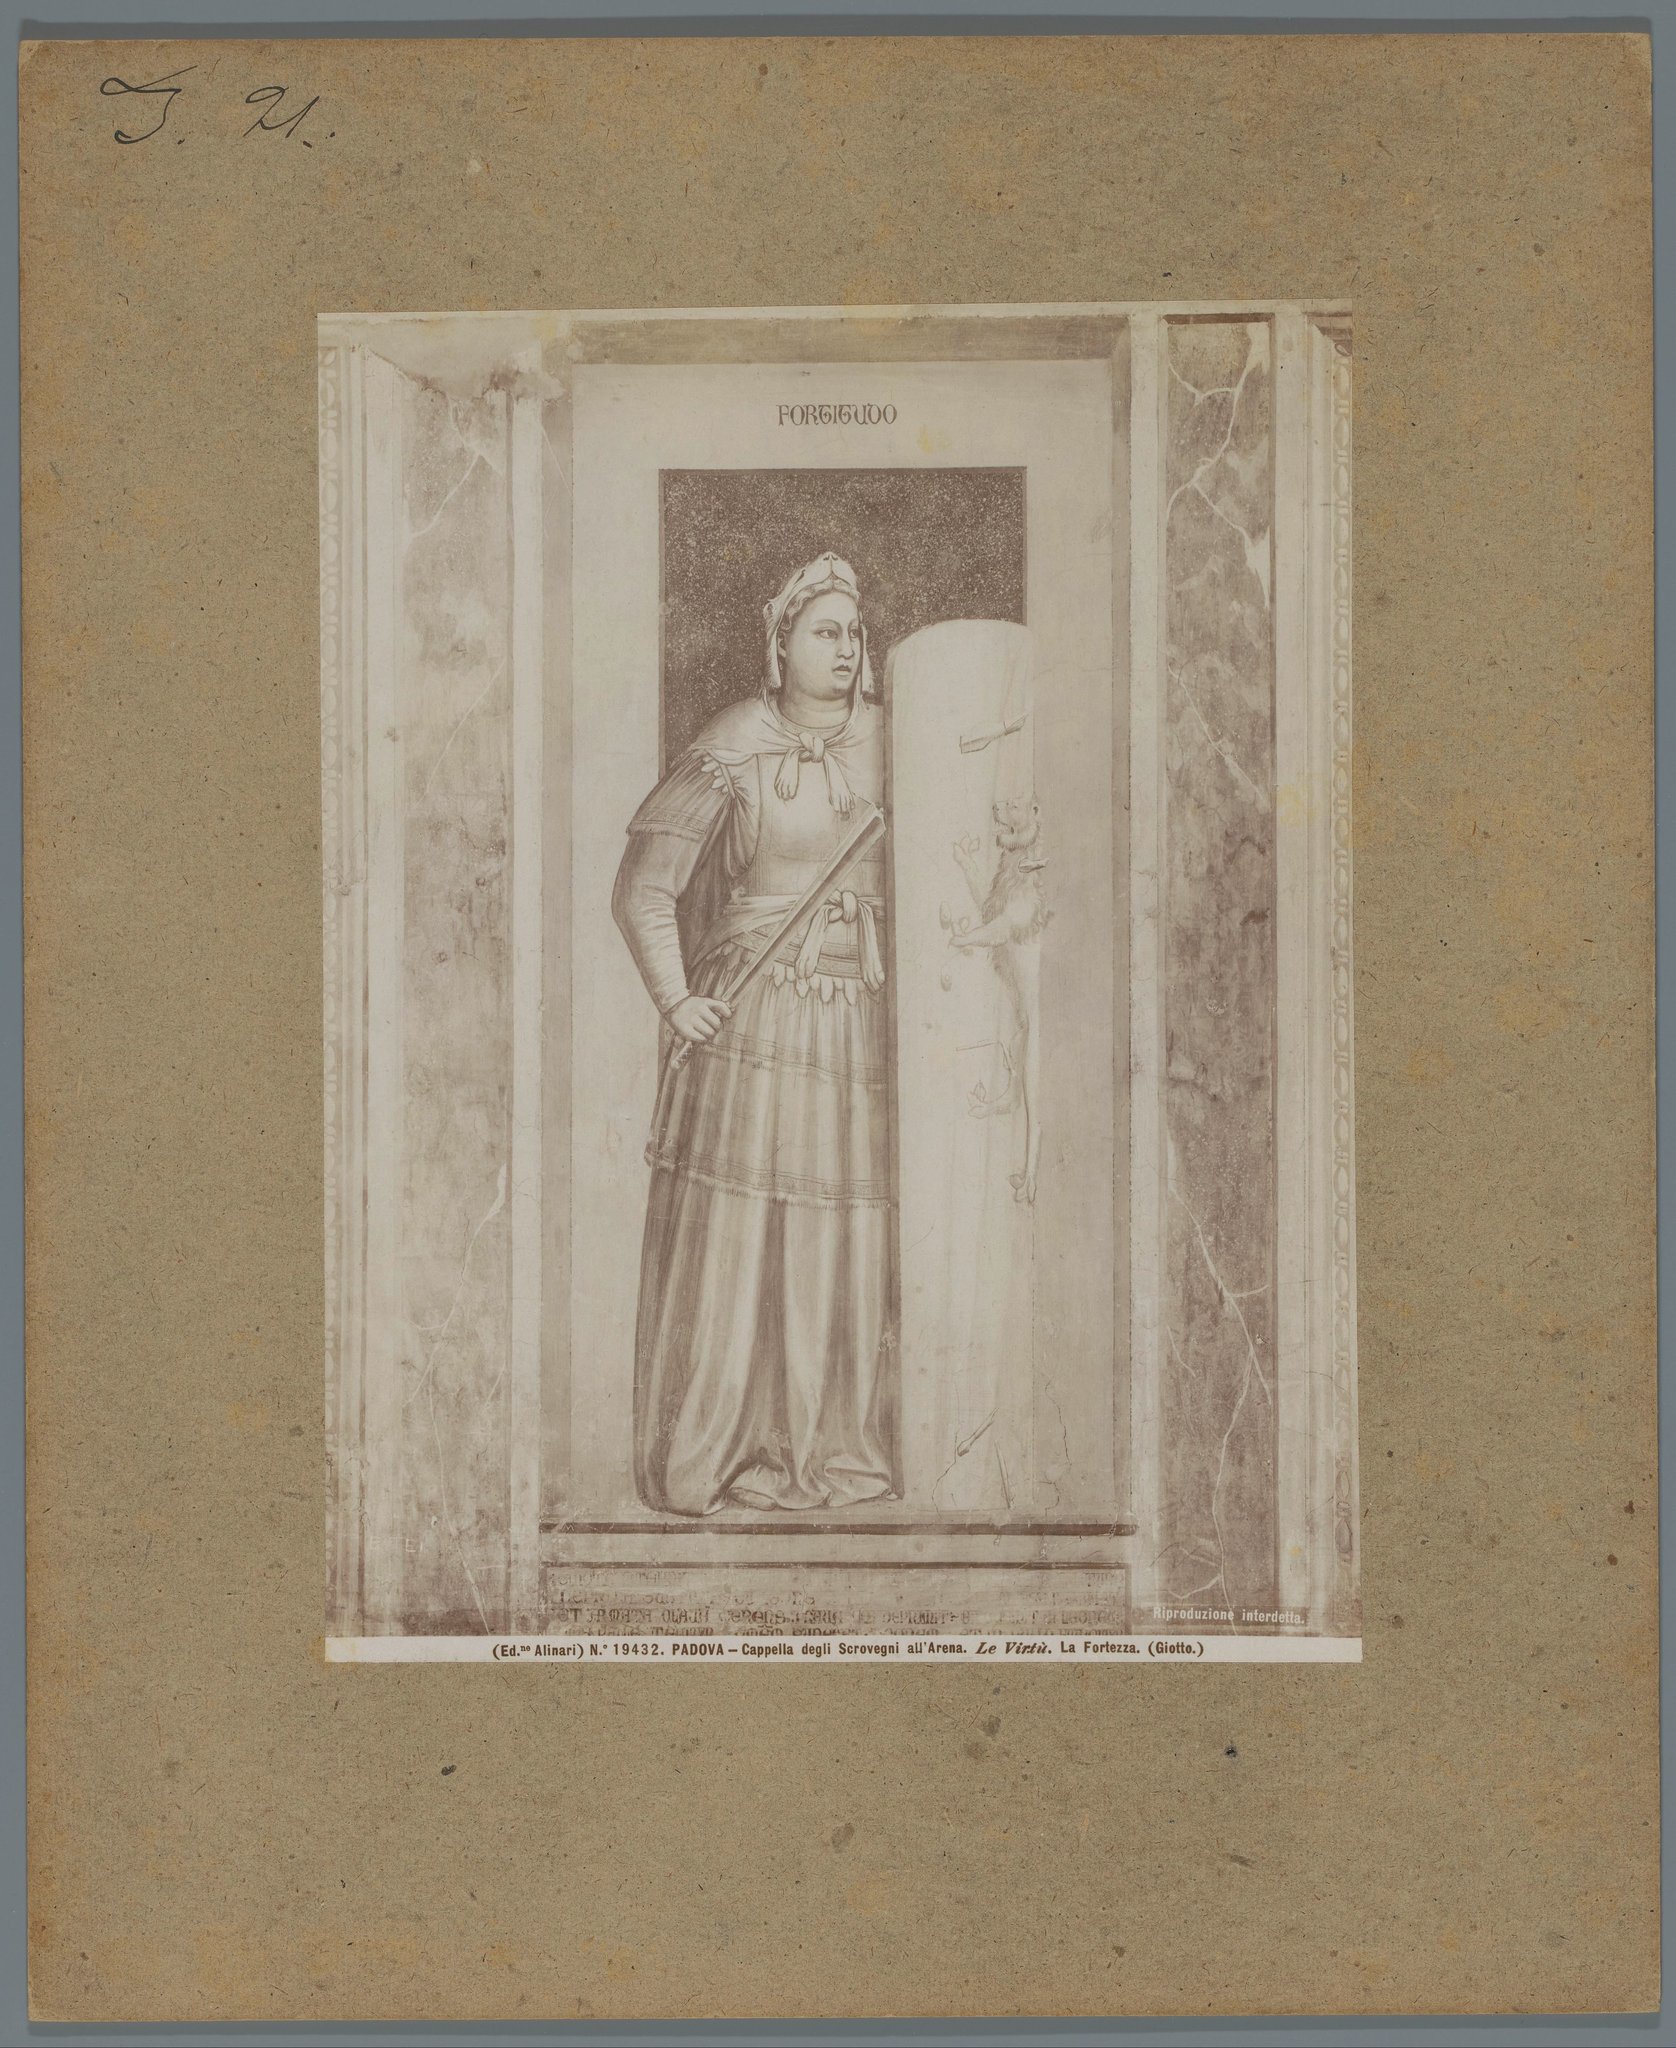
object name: photograph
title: Fotoreproductie van een schildering door Giotto in de Scrovegnikapel te Padua, voorstellende de Kracht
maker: giotto de bondone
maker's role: painter, sculptor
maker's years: 1266-1337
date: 1875-1900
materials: cardboard, photographic support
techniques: albumen print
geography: scrovegnikapel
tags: fortitude, 'fortitudo' ~ one of the four cardinal virtues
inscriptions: collector's mark: Lugt 3937, number: ‘No. 19432.’